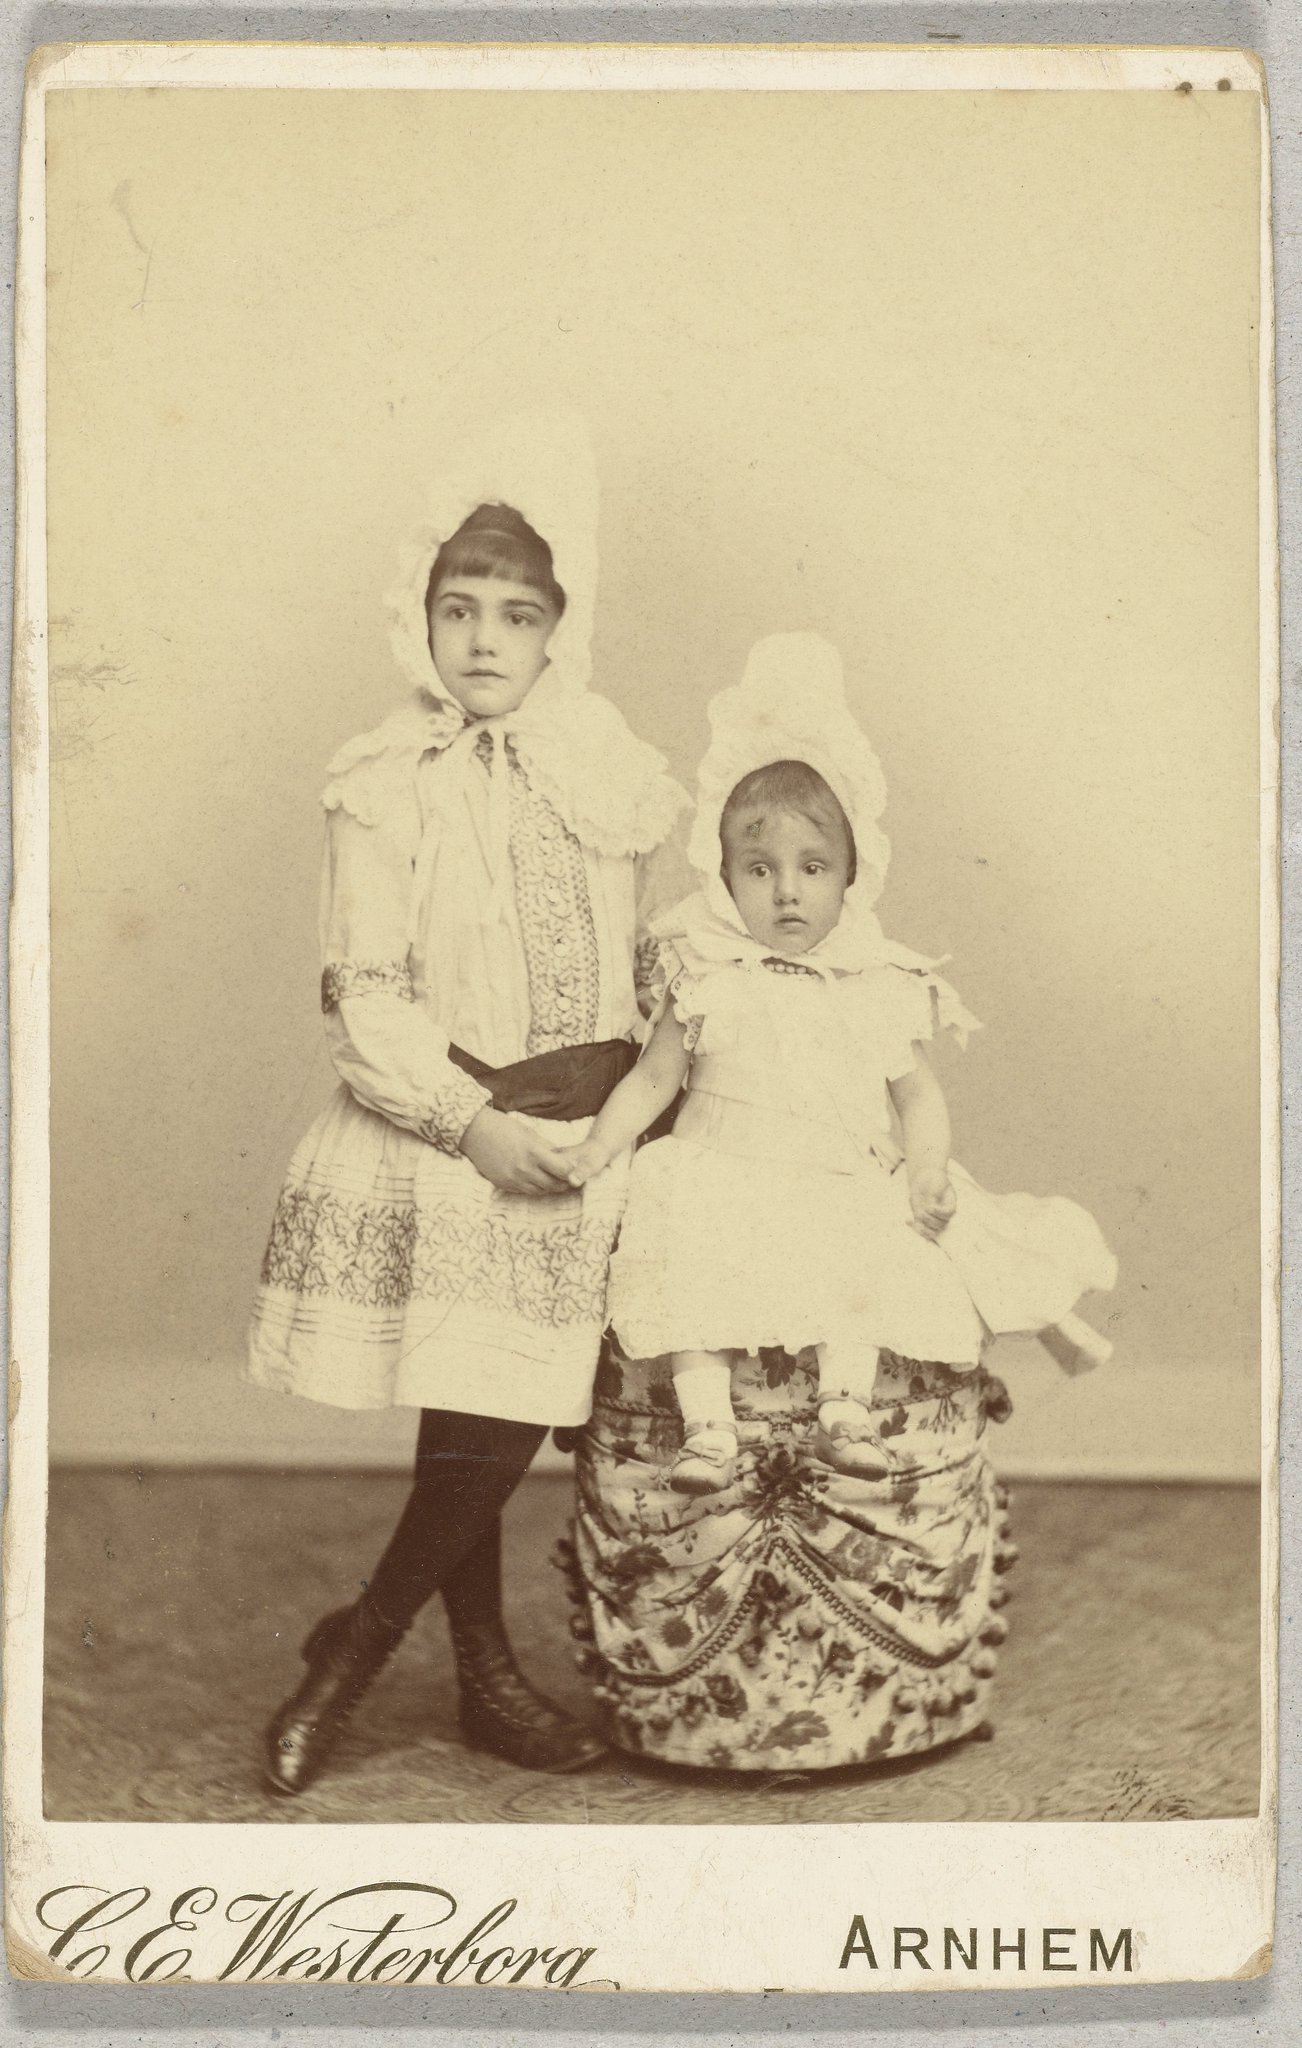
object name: cabinet photograph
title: Dubbelportret van Adeh en Charlotte (Loty) van Braam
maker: carel eduard westerborg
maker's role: fotograaf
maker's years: 1842-1916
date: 1890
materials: cardboard, paper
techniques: albumen print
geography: arnhem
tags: charlotte van braam, historical persons - bb - woman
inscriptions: signature: ‘C.E. Westerborg Arnhem’